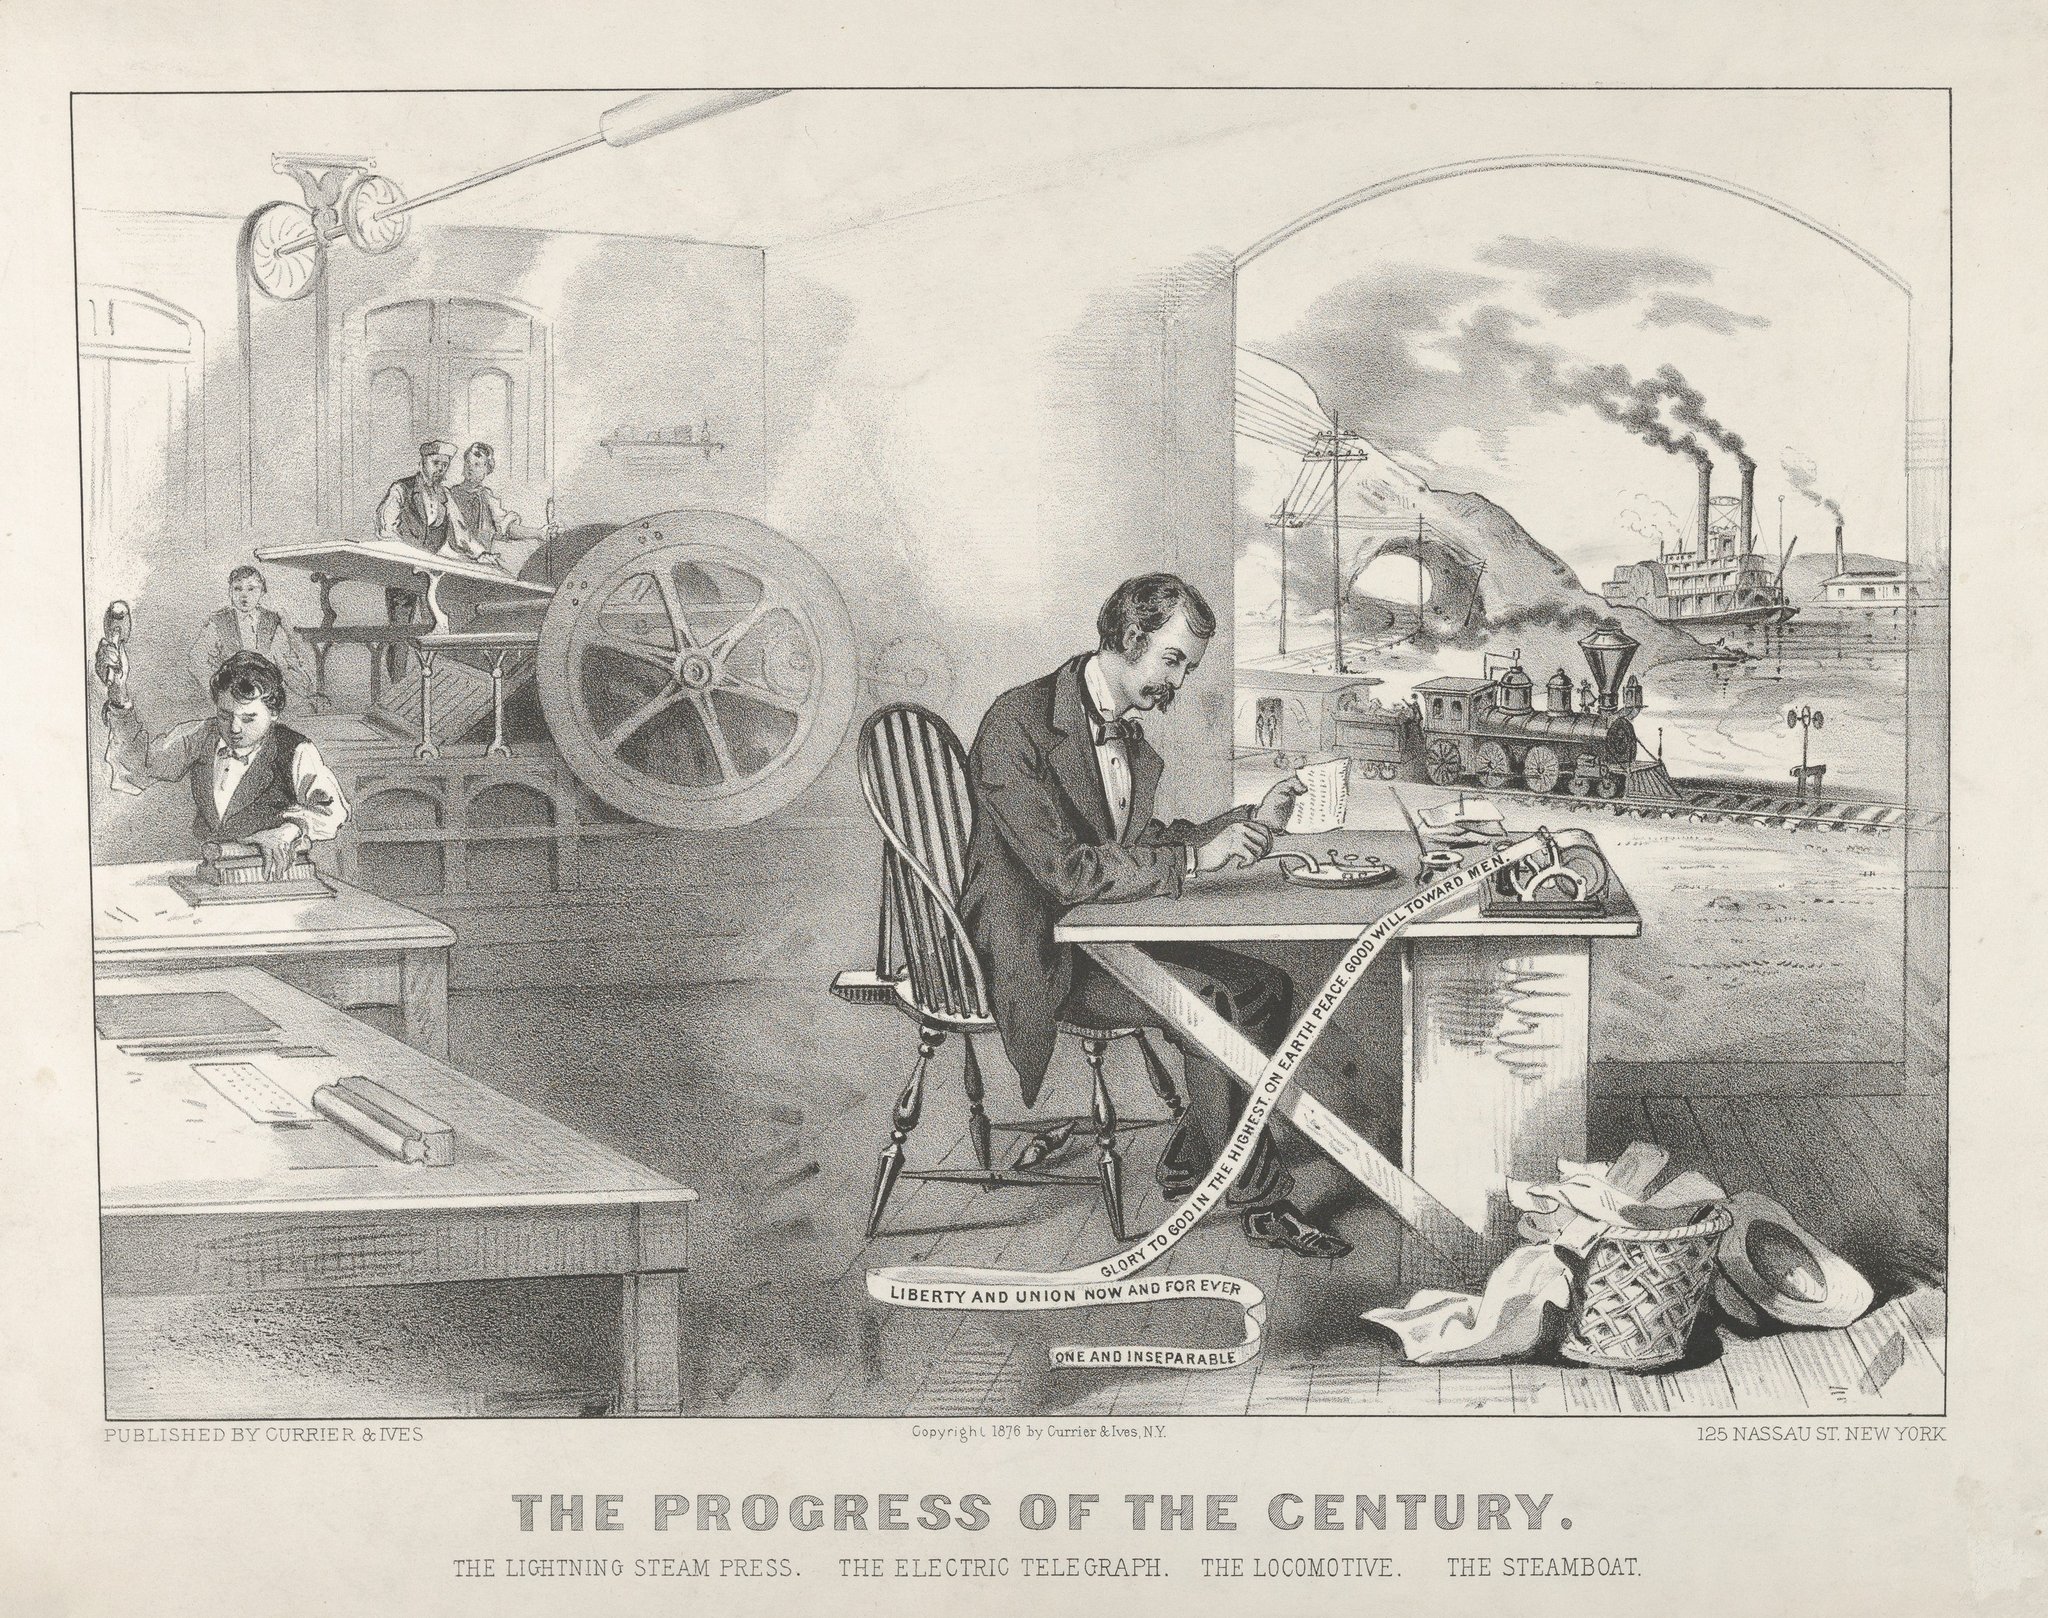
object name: print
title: The Progress of the Century – The Lightning Steam Press. The Electric Telegraph. The Locomotive. The Steamboat.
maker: currier & ives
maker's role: publisher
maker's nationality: american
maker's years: 1857-1907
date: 1876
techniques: lithograph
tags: men,industry,trains,printing press